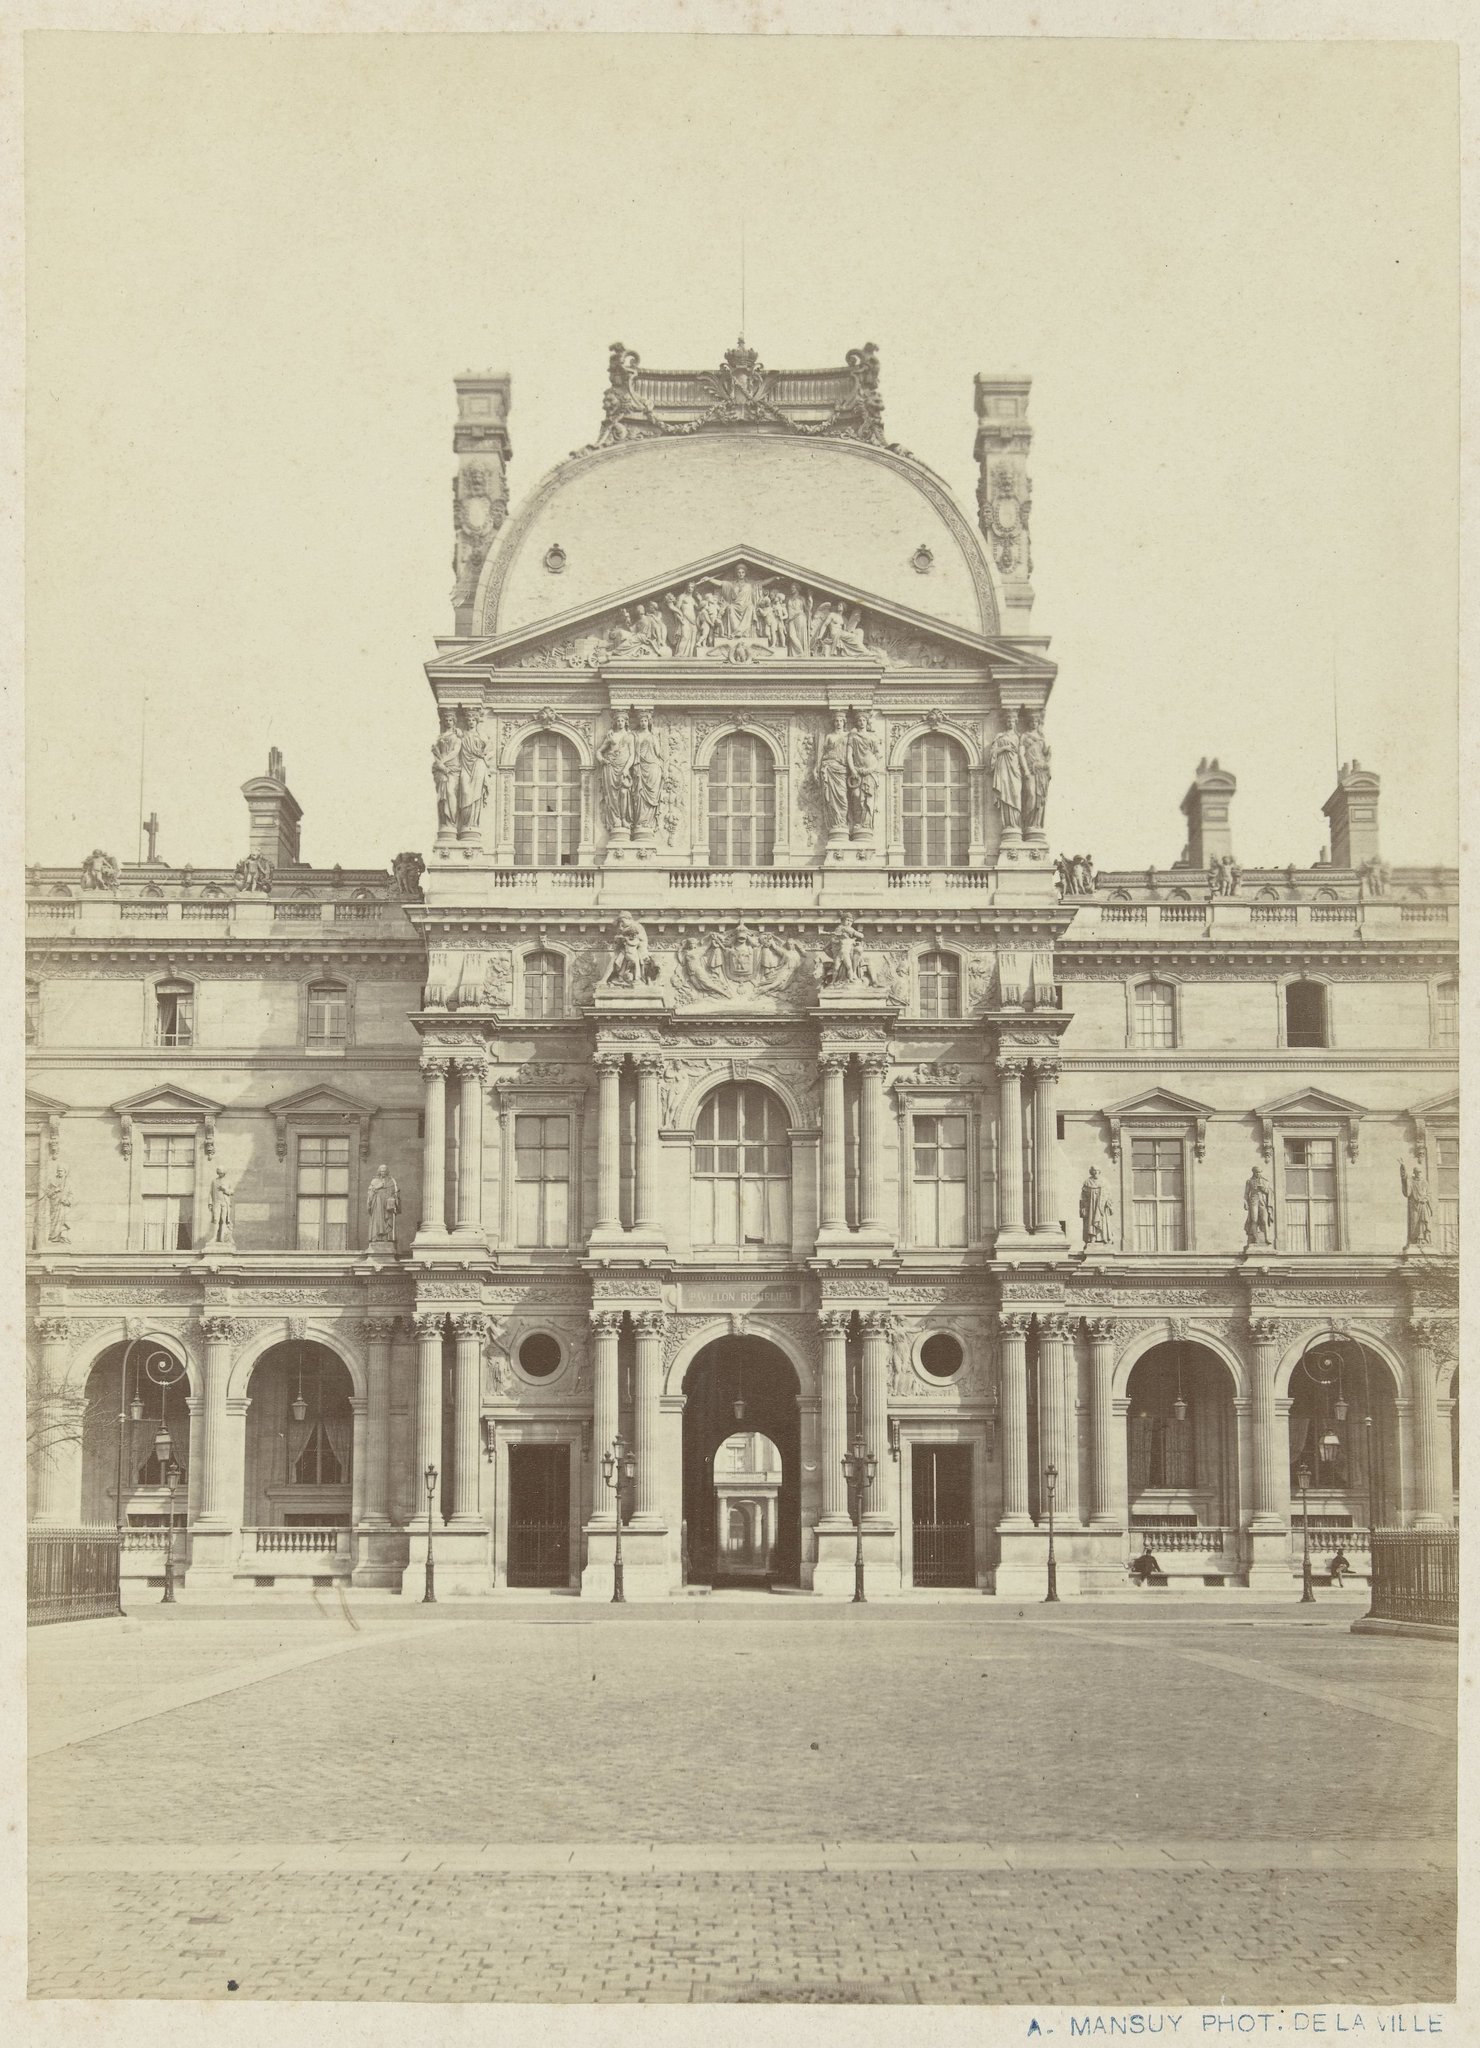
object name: photograph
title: Paviljoen van het Louvre te Parijs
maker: albert mansuy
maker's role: fotograaf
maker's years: 1831-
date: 1860-1880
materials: cardboard, paper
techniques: albumen print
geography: paris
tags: permanent exhibition, museum, exterior ~ representation of a building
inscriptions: inscription: ‘Le Louvre’, number: ‘14’